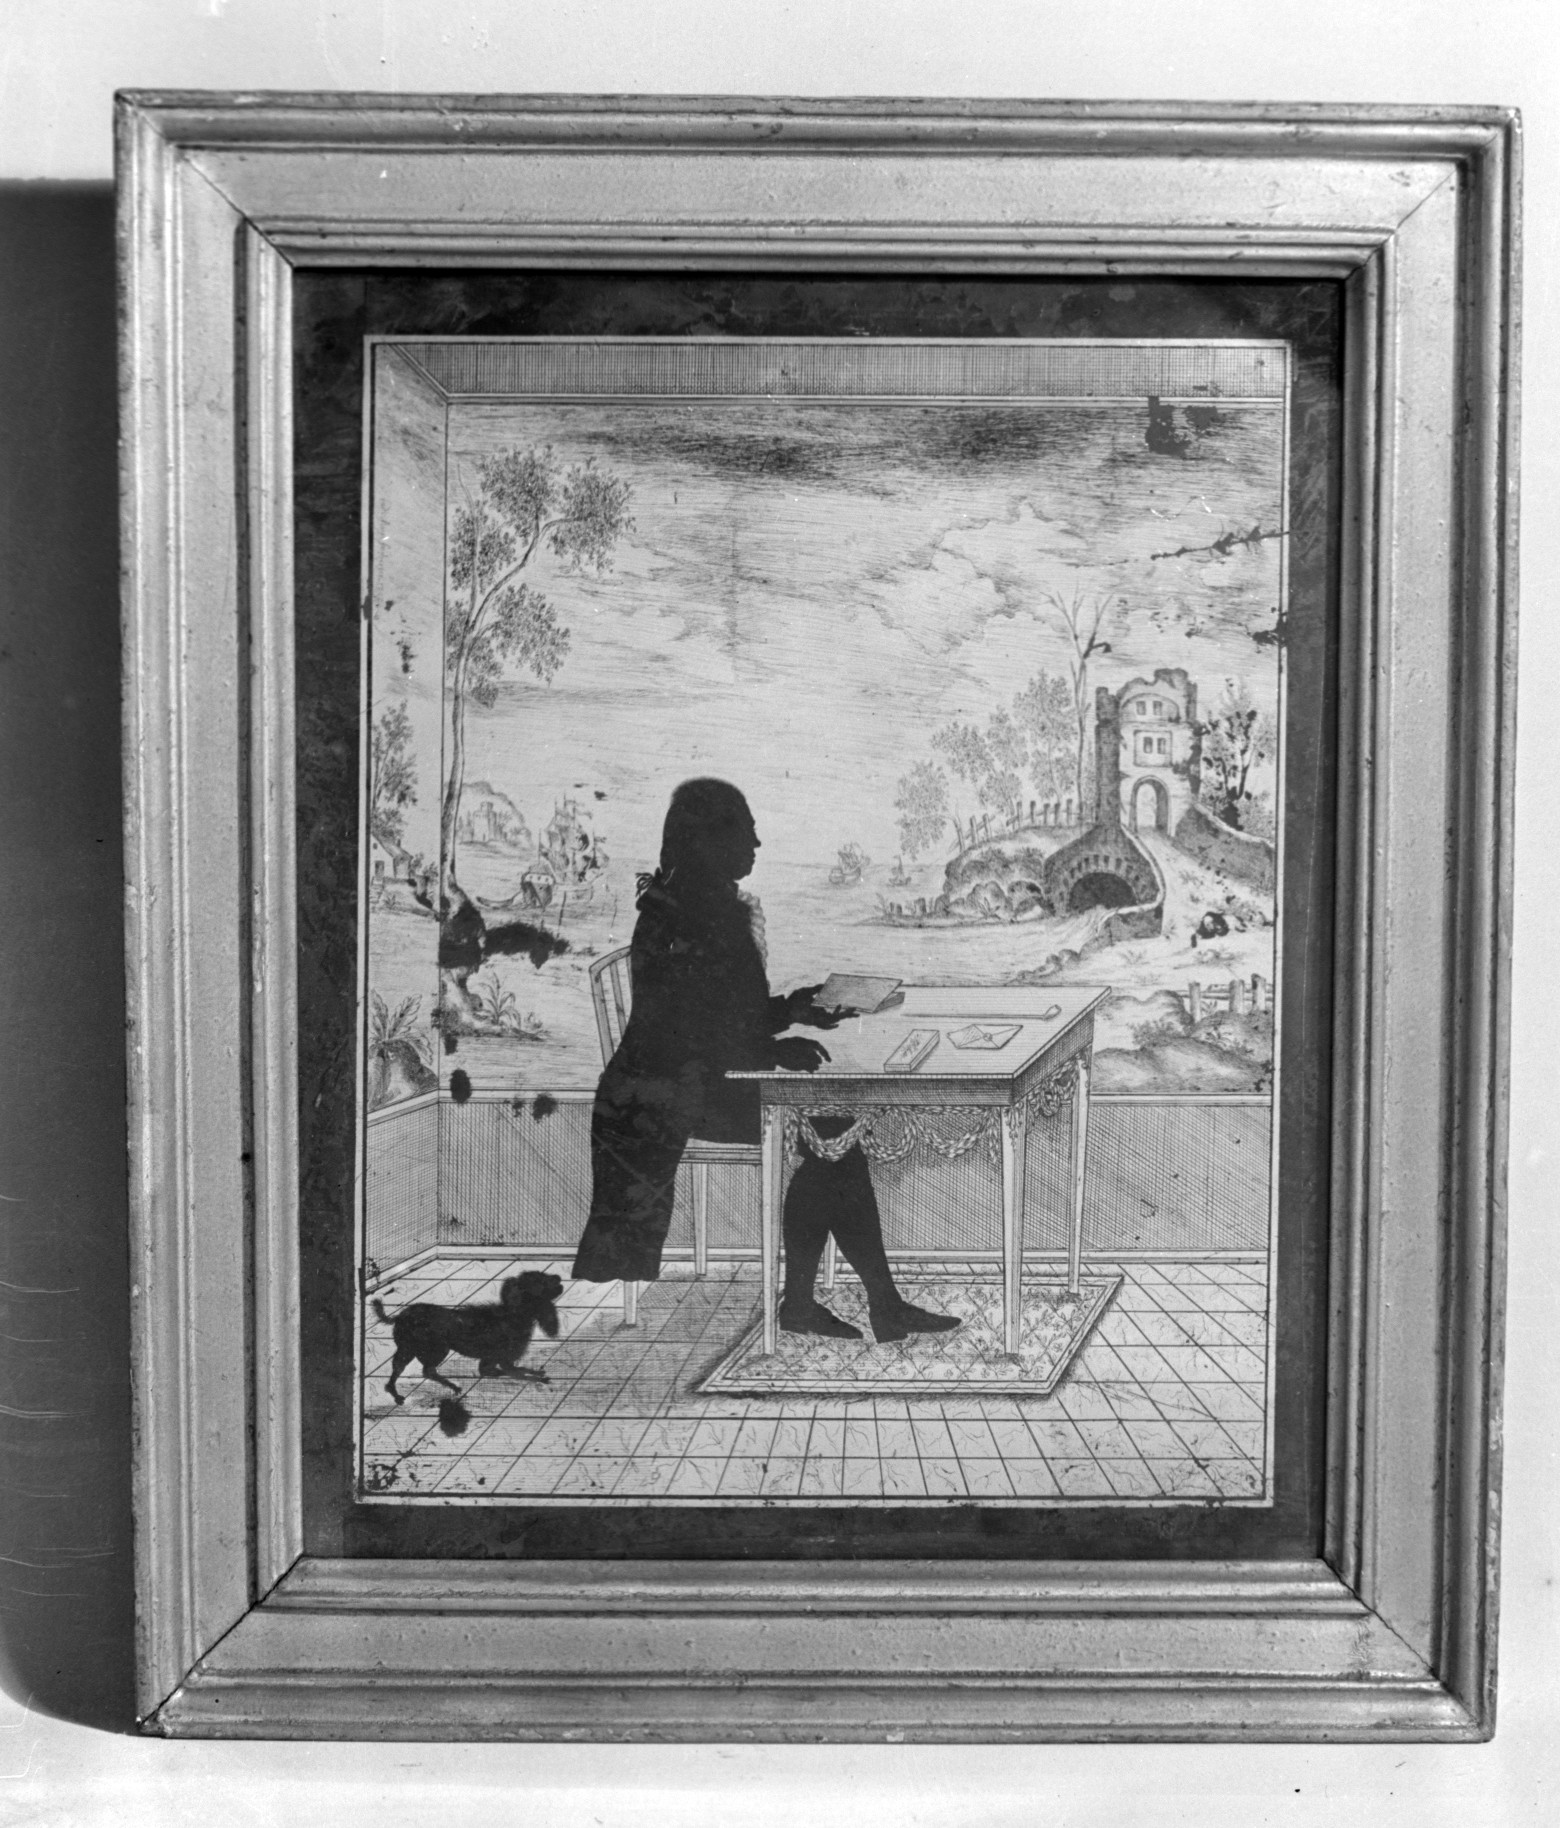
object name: panel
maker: aug. forberger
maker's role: artist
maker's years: 1762-1865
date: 1797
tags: human figures,dogs,trees,writing